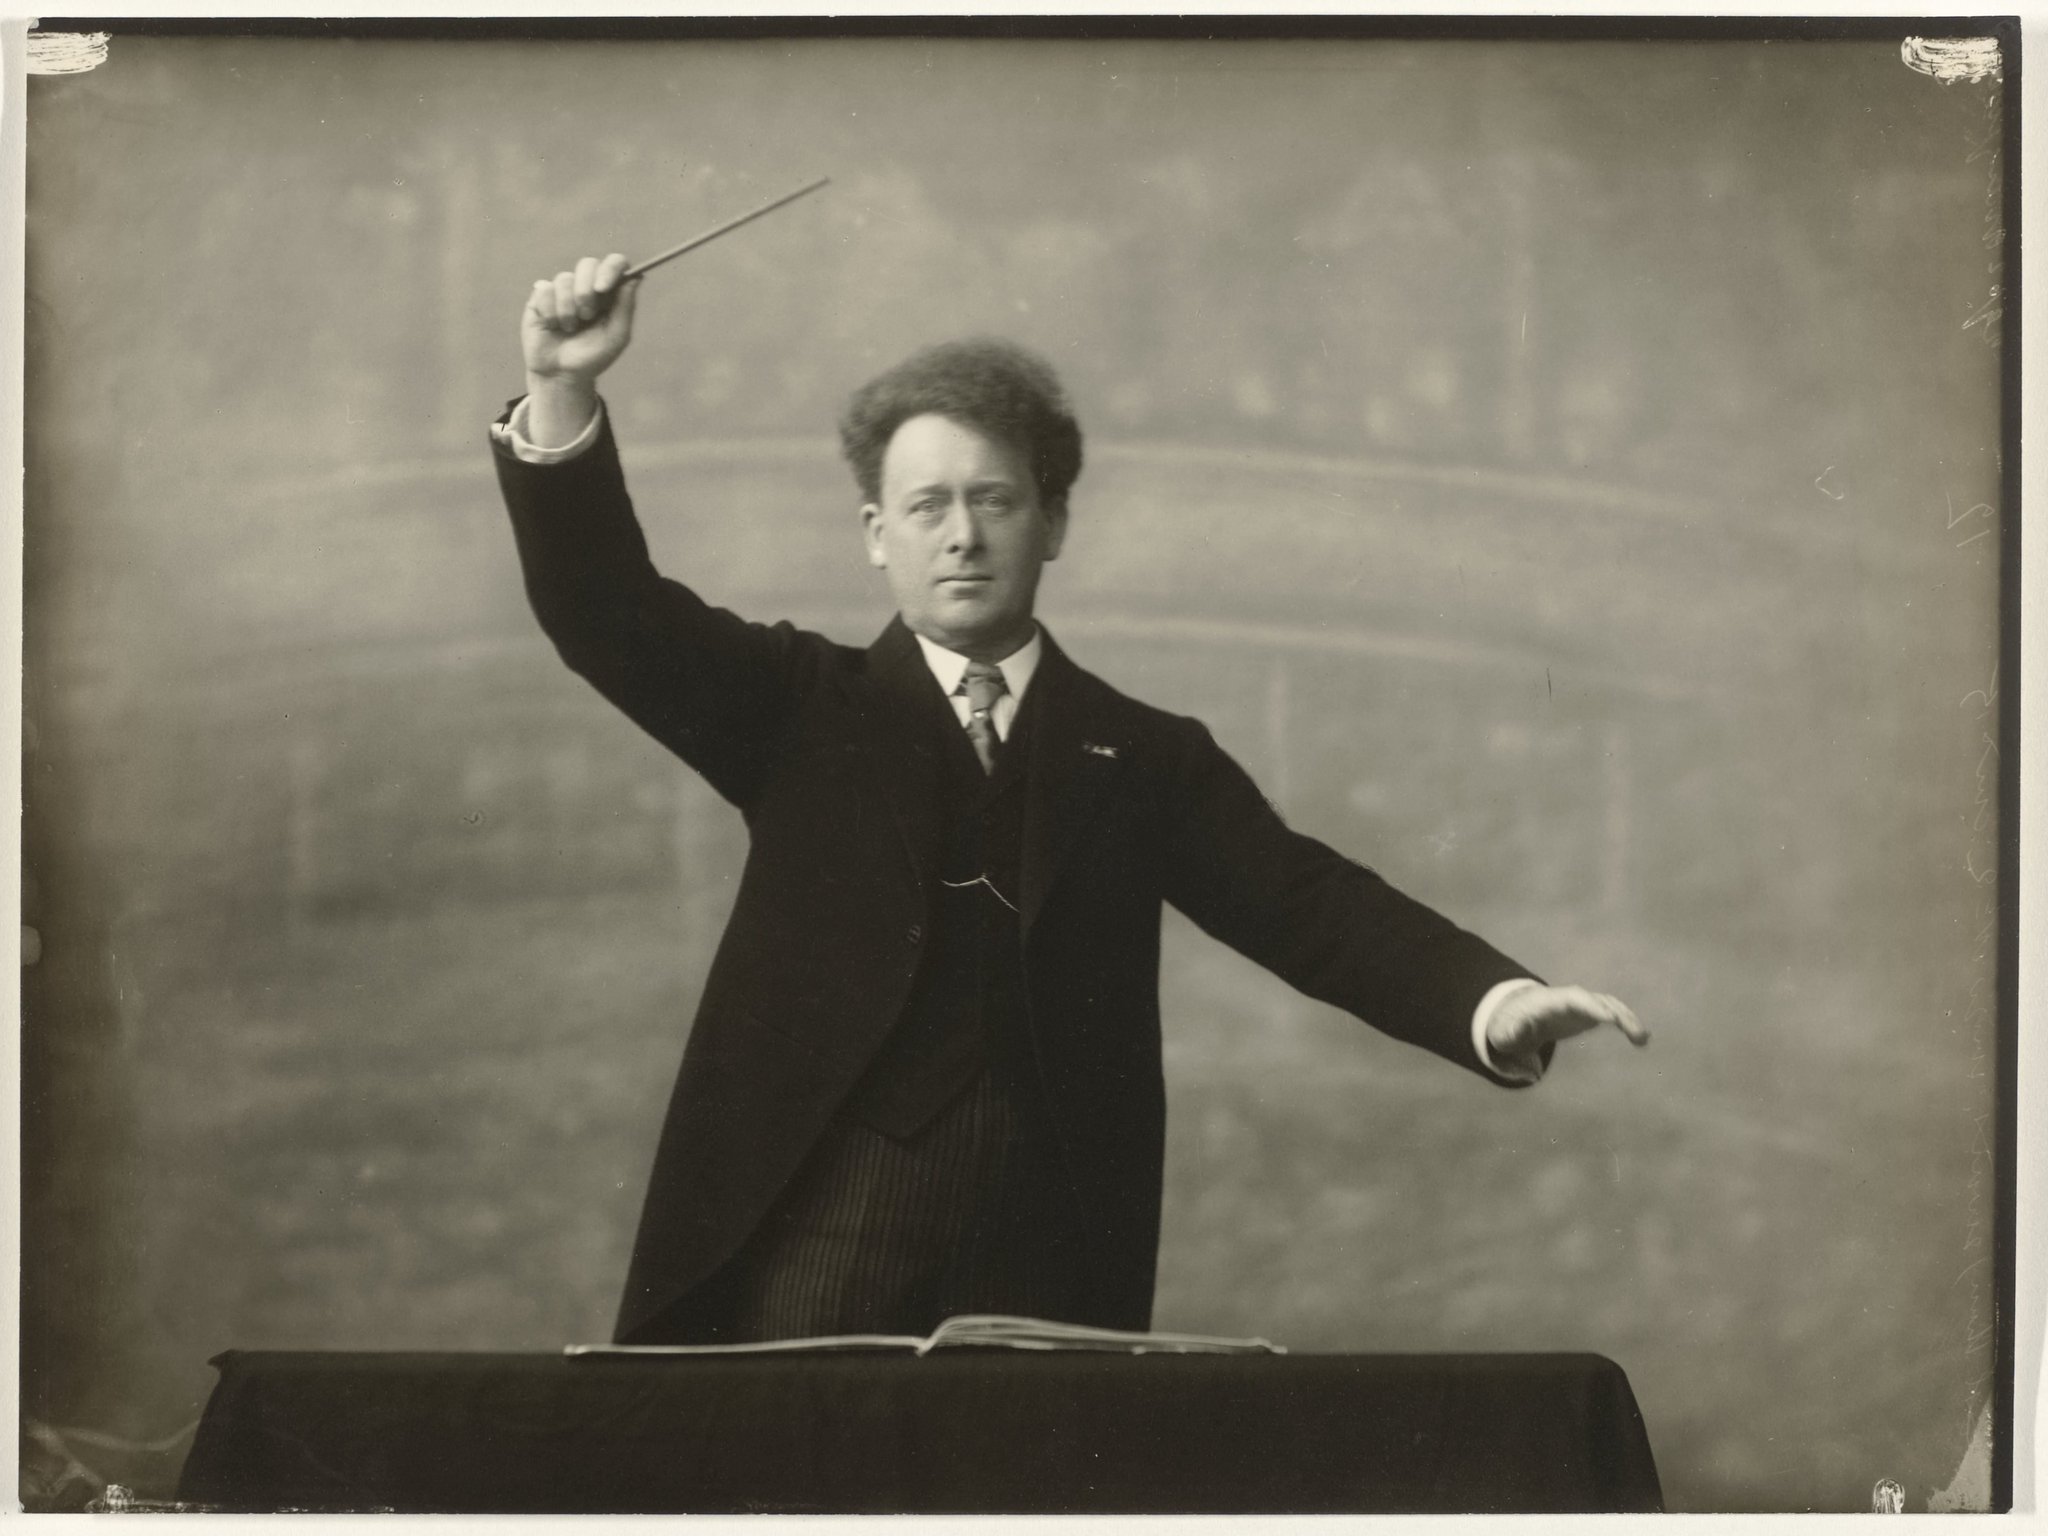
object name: photograph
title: Studioportret van dirigerende Willem Mengelberg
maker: jacob merkelbach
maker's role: fotograaf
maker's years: 1877-1942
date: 1919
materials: photographic support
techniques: gelatin silver print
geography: amsterdam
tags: utrecht, conductor ~ music, historical persons (portraits and scenes from the life), amsterdam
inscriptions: annotation: ‘Foto J Merkelbach (met op negatief ingekleurde achtergrond) gaslichtpapier’, number: ‘15’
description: atelieropname met geschilderde achtergrond